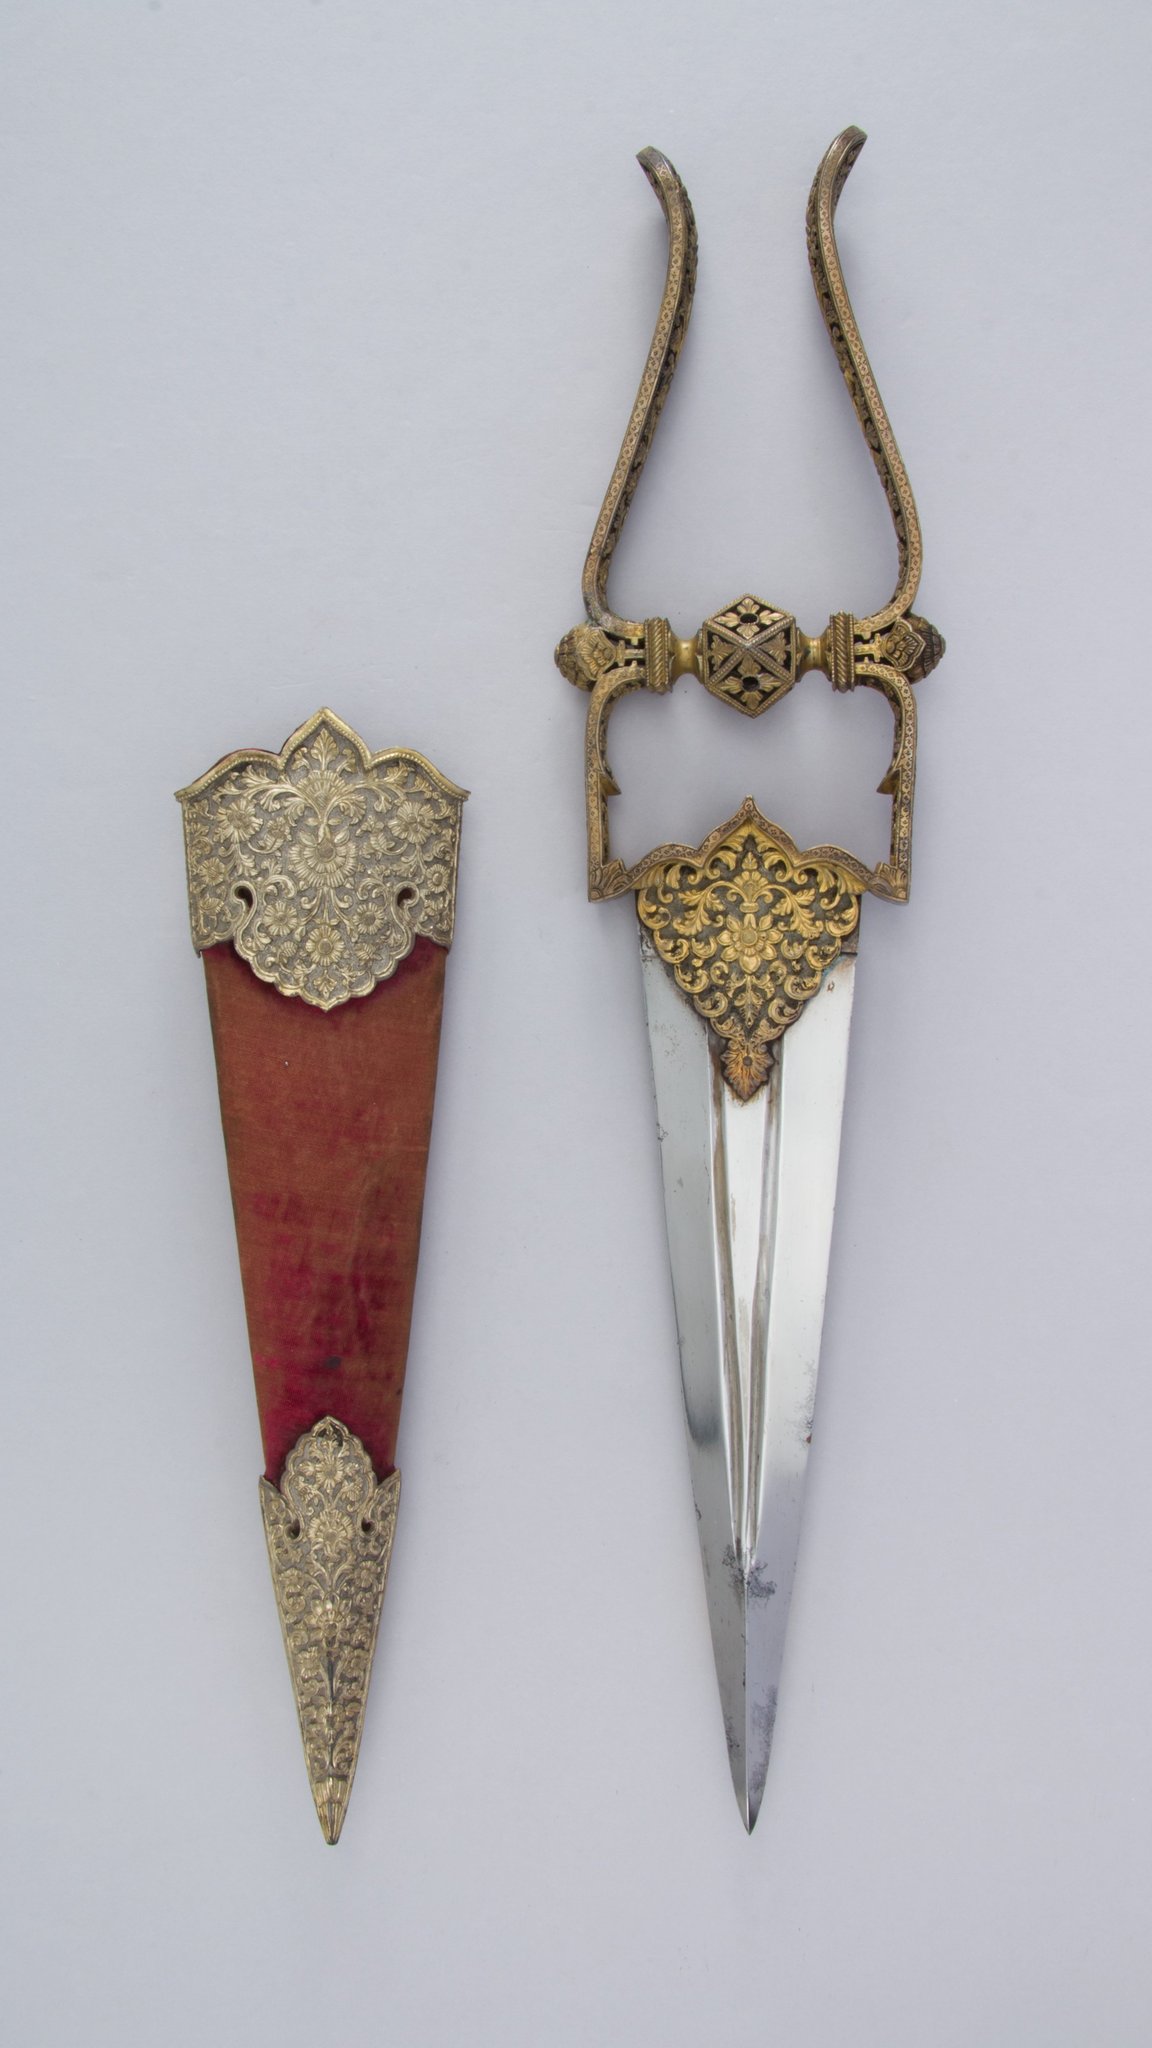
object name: dagger with sheath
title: Dagger (Katar) with Sheath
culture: indian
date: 1801-1900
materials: gold, silver, steel, velvet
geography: india